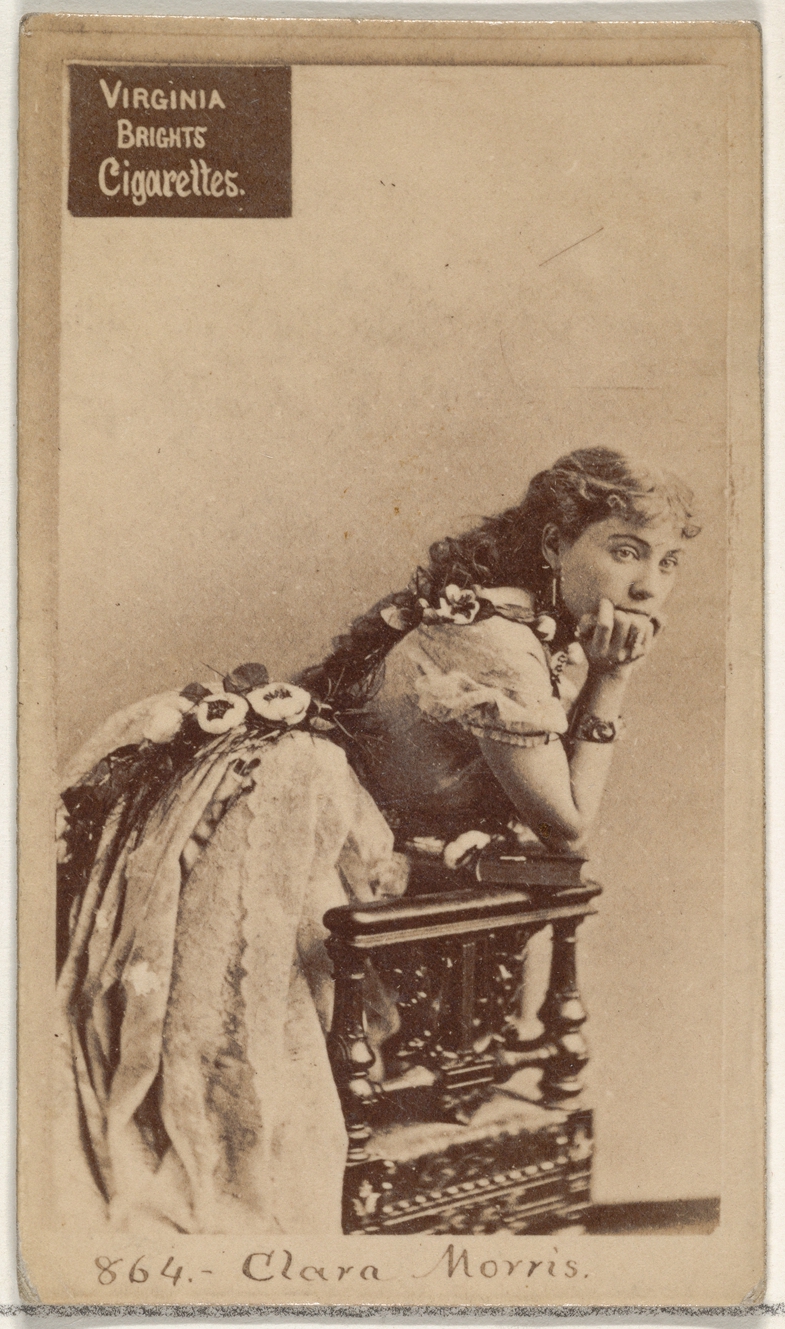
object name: photograph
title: Card 864, Clara Morris, from the Actors and Actresses series (N45, Type 2) for Virginia Brights Cigarettes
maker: allen & ginter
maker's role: publisher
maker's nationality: american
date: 1888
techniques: albumen silver print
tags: portraits,women,actresses